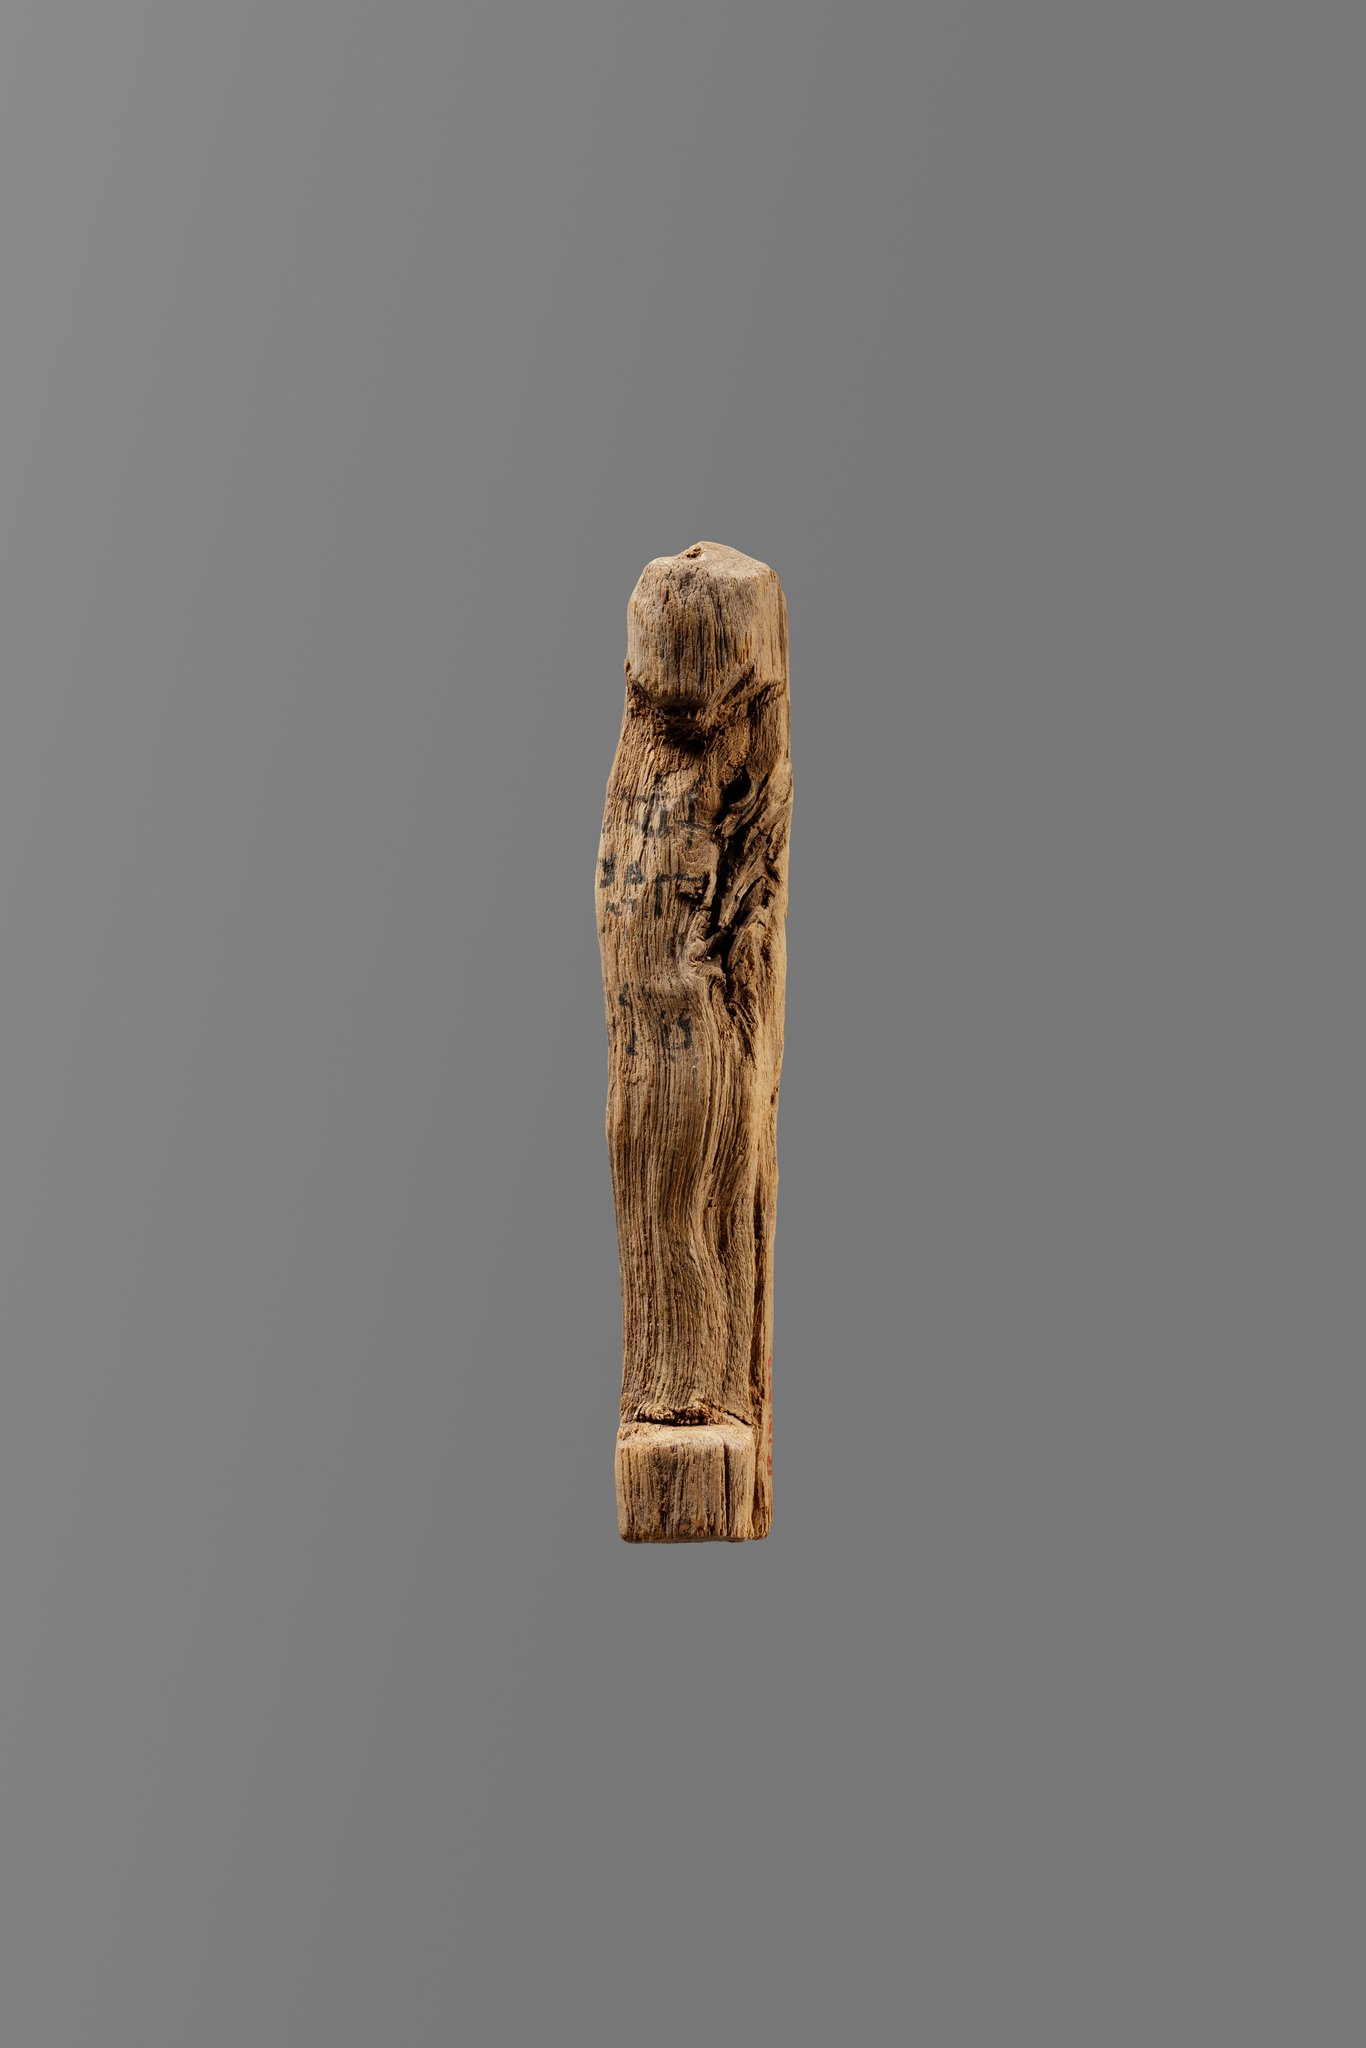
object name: shabti, tetinefer, tetiky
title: Shabti of Tetinefer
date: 1570-1525 BCE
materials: wood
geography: egypt